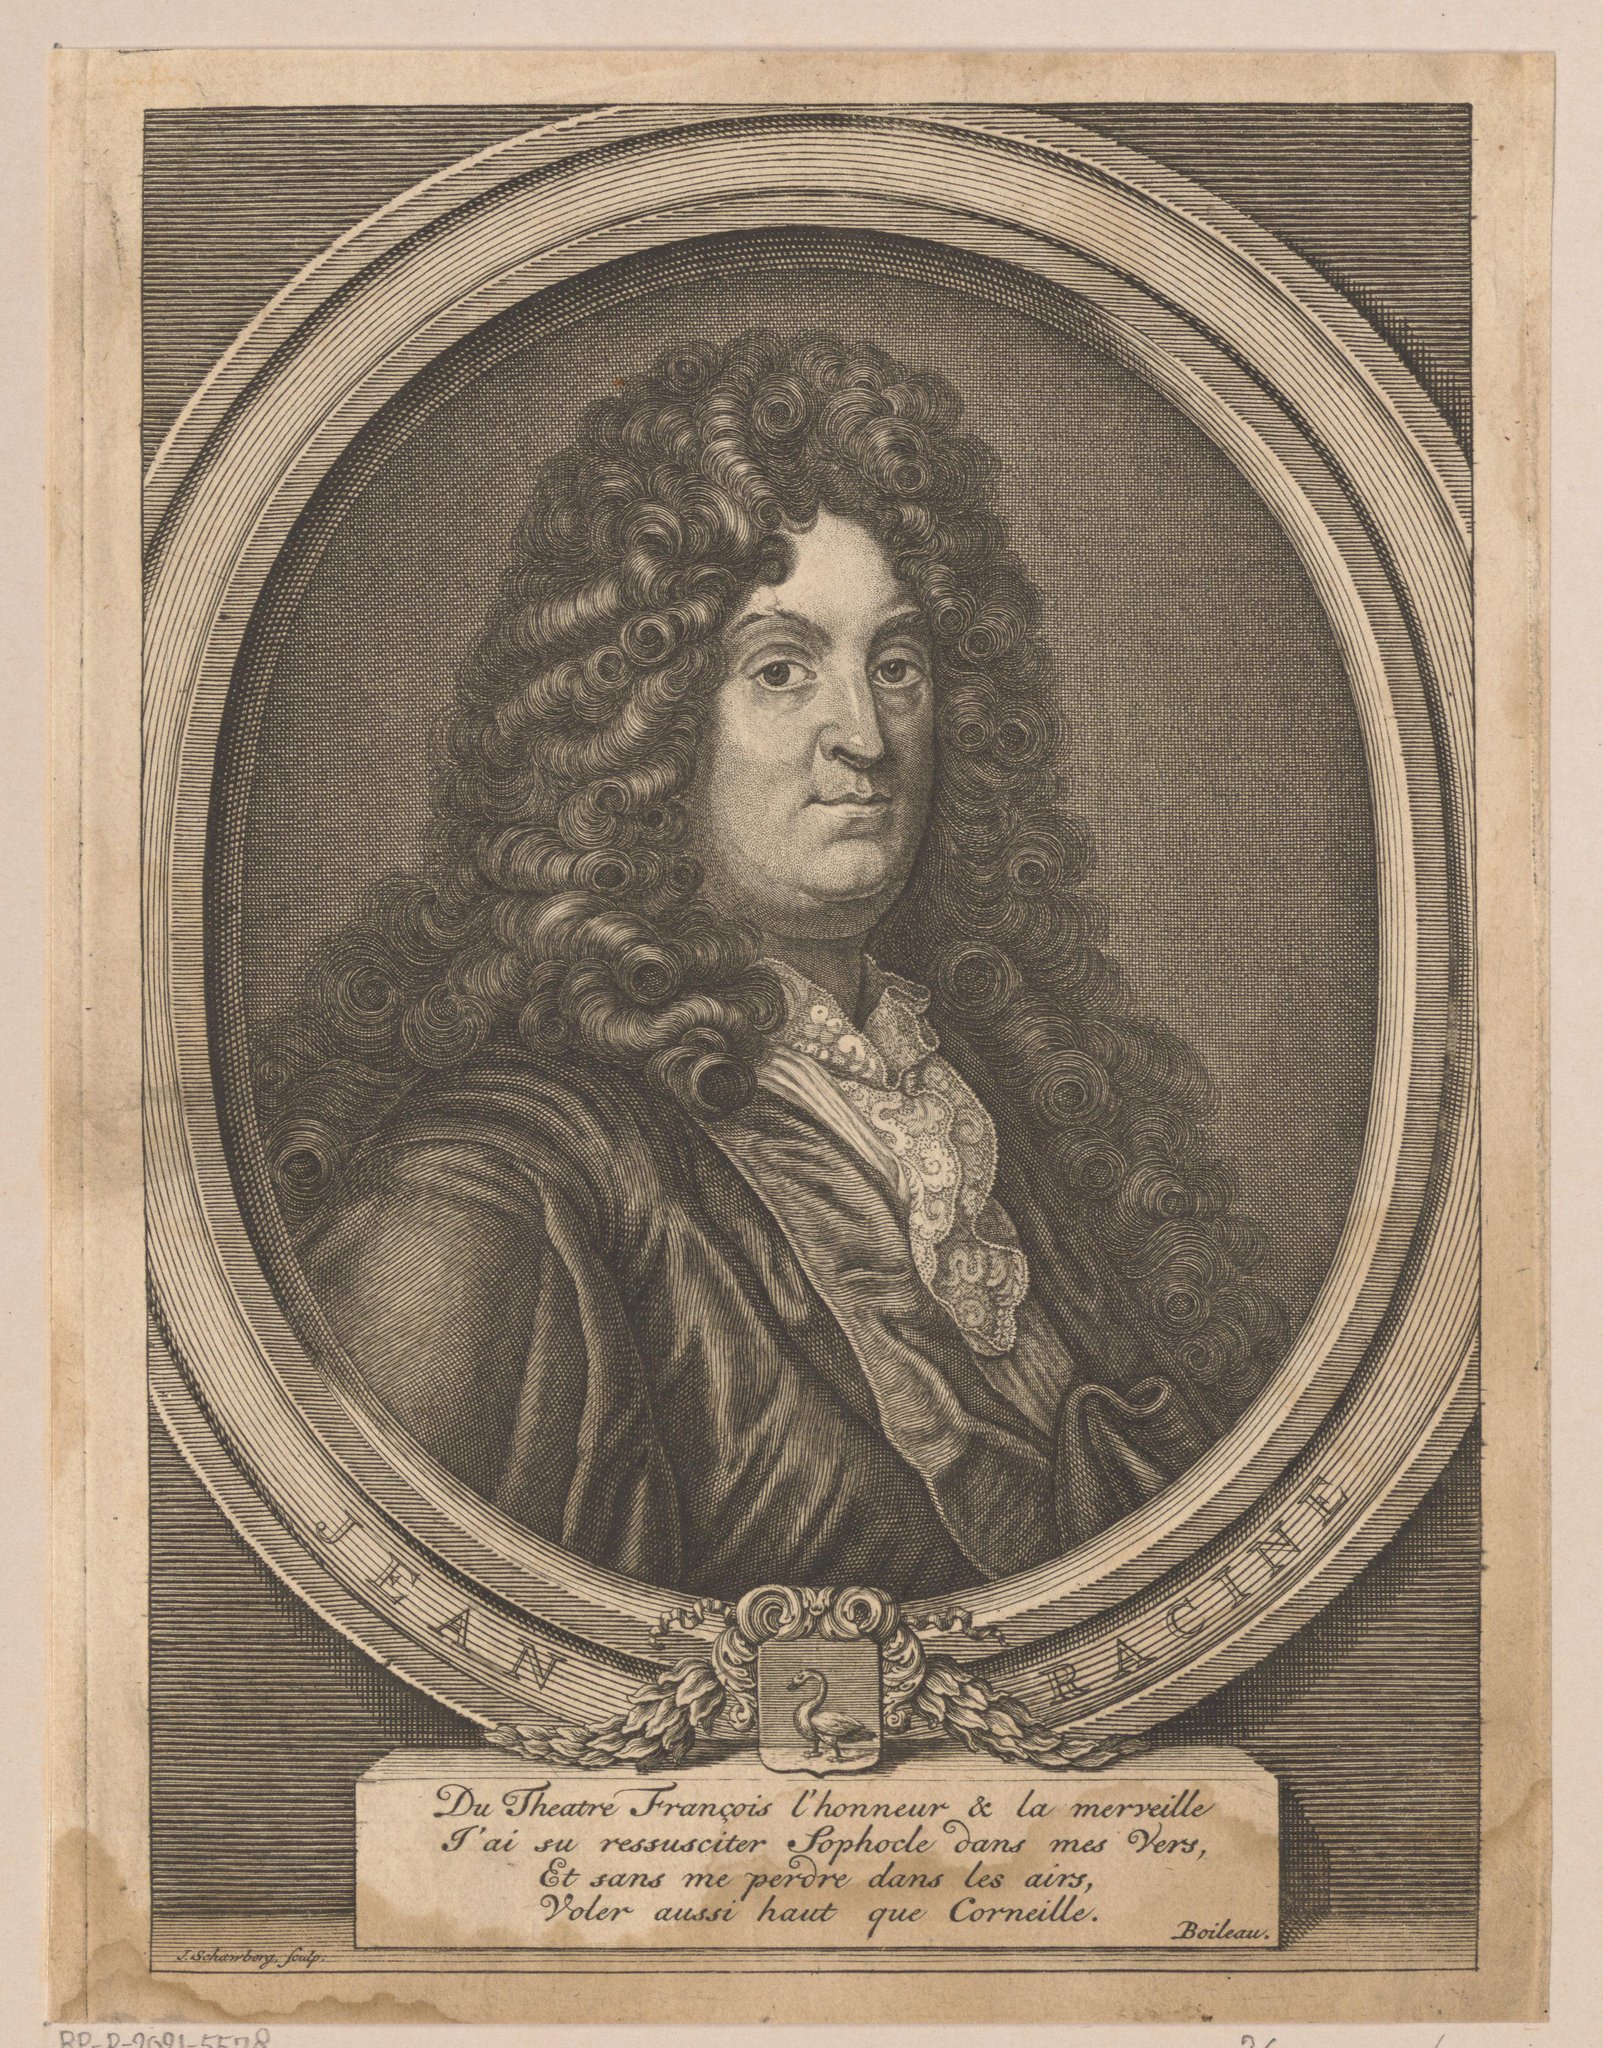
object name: print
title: Portret van Jean Racine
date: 1727-1760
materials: paper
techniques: engraving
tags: france, jean racine, historical persons, portrait of a writer, armorial bearing, heraldry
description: Onder het portret zijn wapenschild. Onder het wapenschild een vierregelig vers.